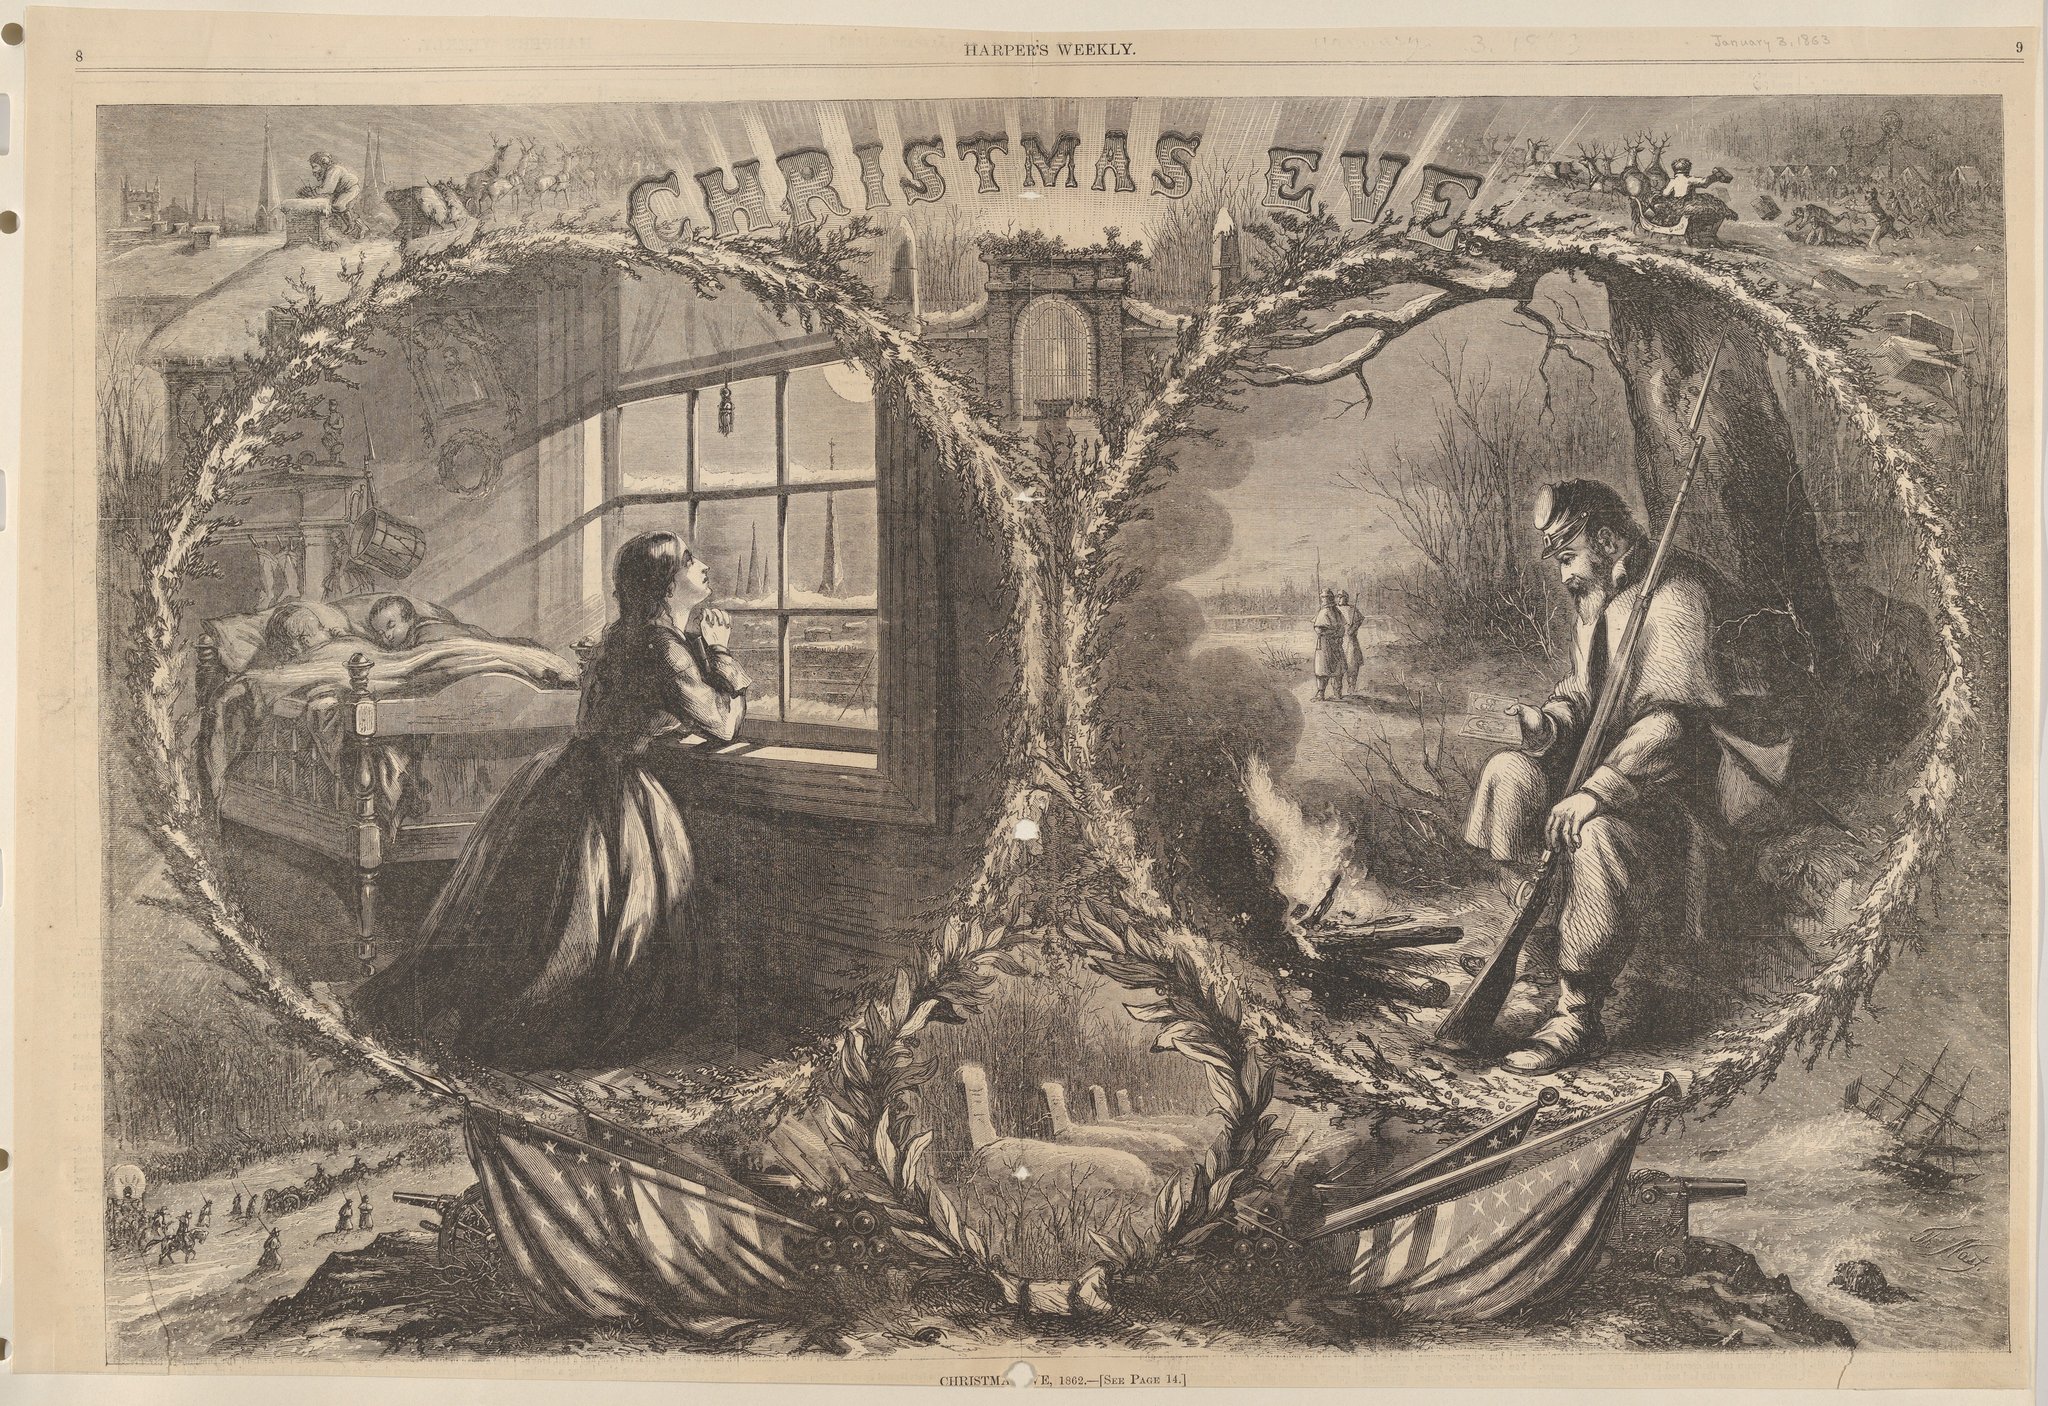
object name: print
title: Christmas Eve, 1862 (from "Harper's Weekly," vol. 7, pp. 8-9)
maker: thomas nast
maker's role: artist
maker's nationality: american, born germany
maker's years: 1840-1902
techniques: engraving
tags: soldiers,american civil war,boys,girls,men,women,christmas